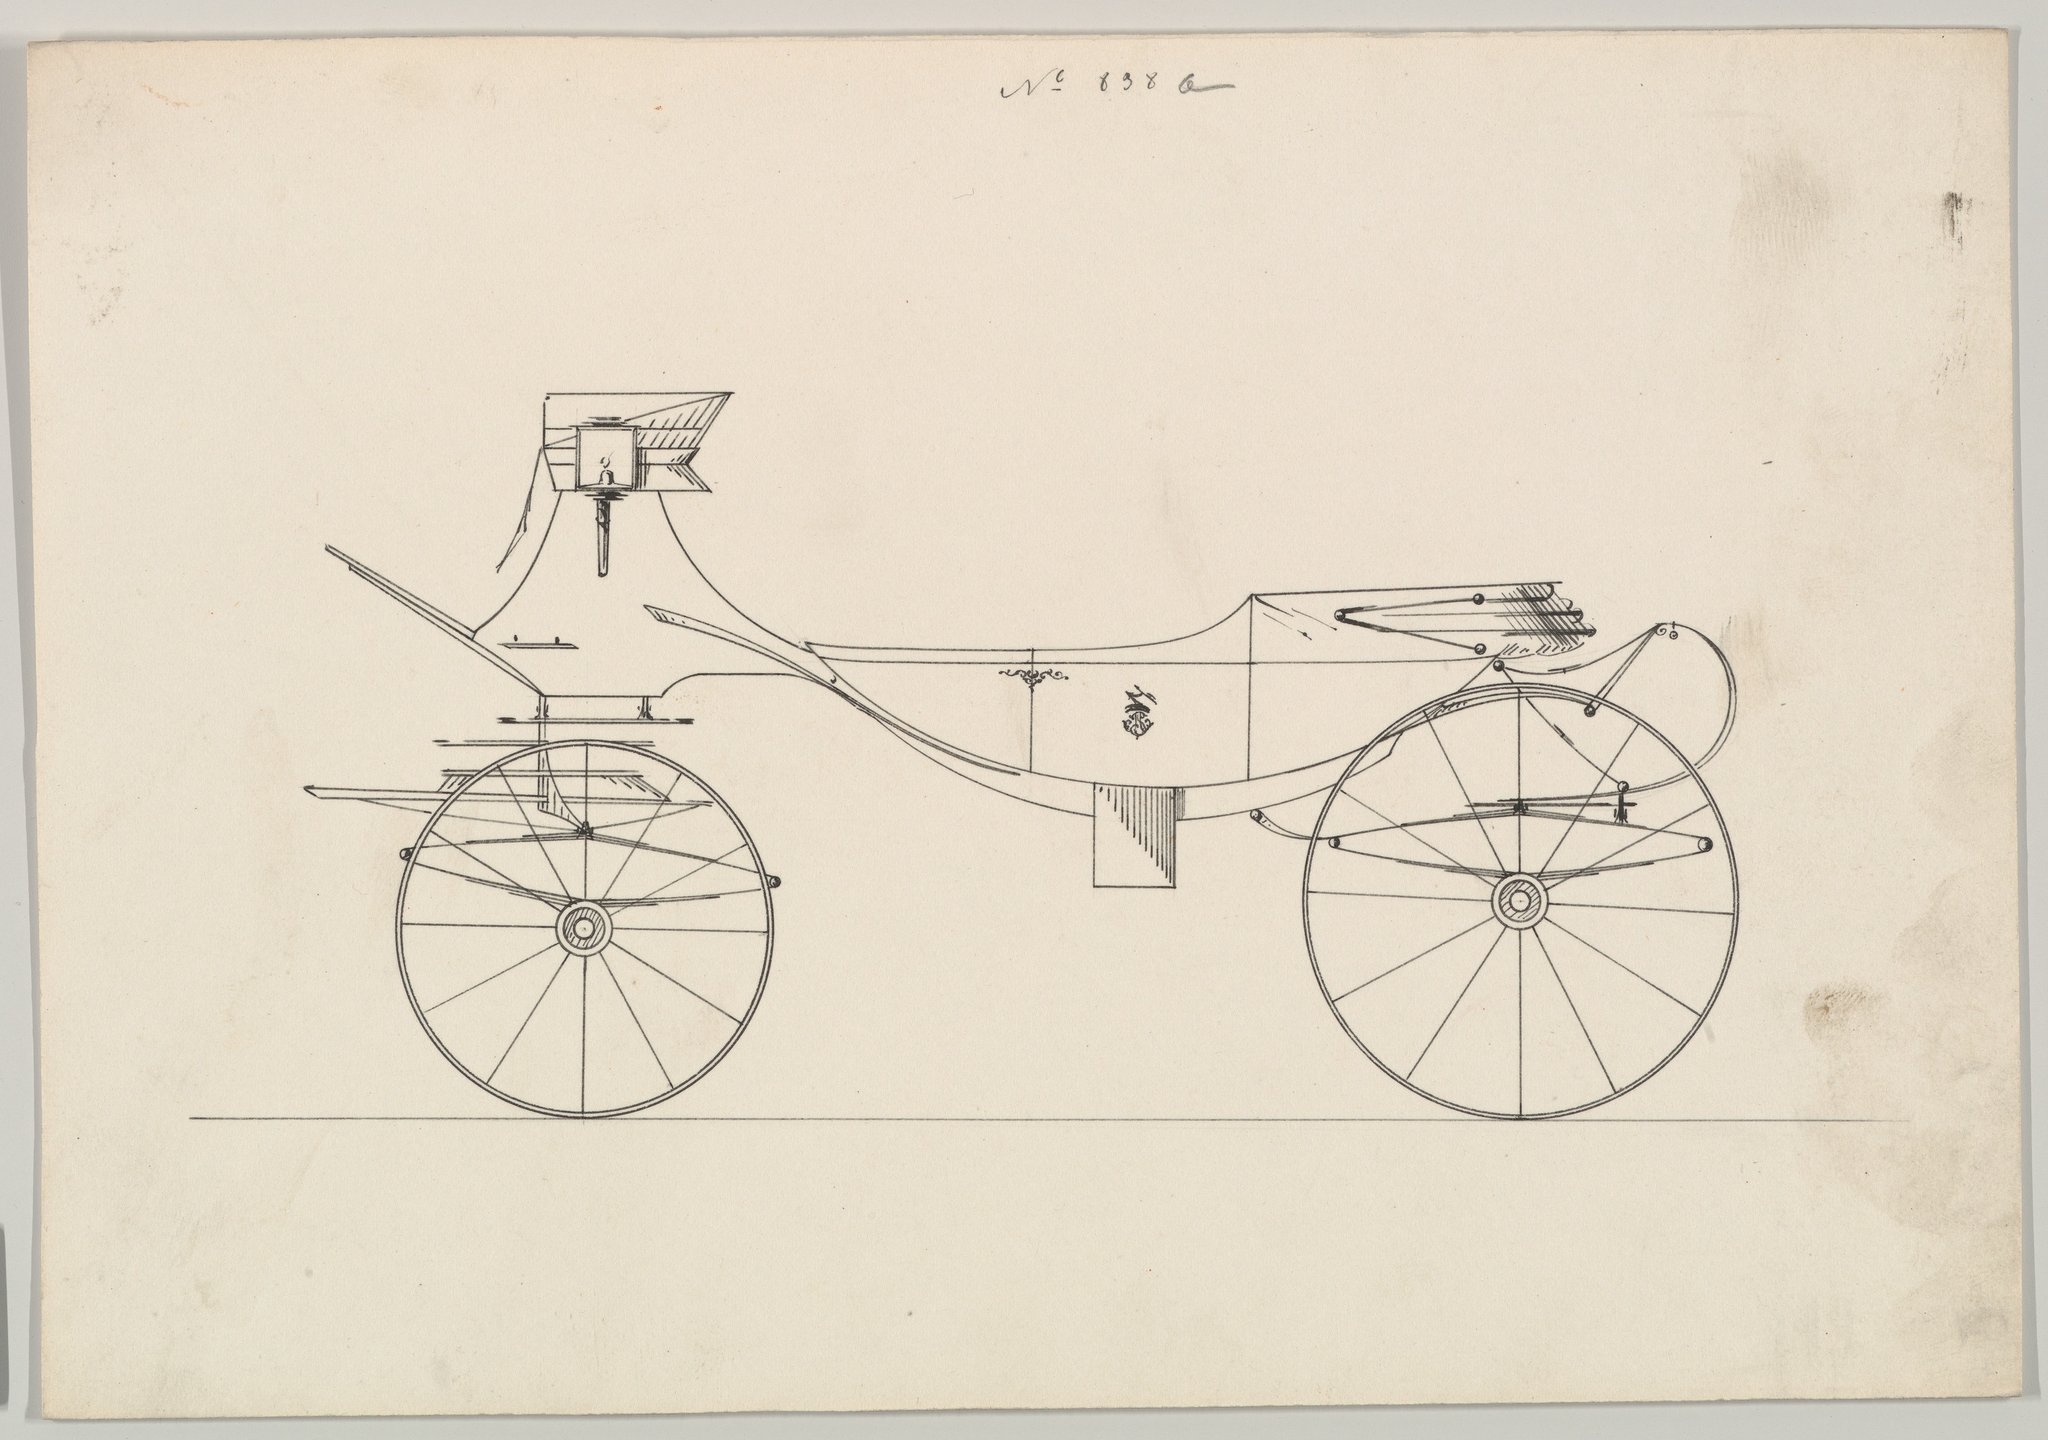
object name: drawing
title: Design for Vis-à-vis/ Barouche, no. 838a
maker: brewster & co.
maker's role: manufacturer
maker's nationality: american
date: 1850-1870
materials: ink, watercolor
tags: carriages